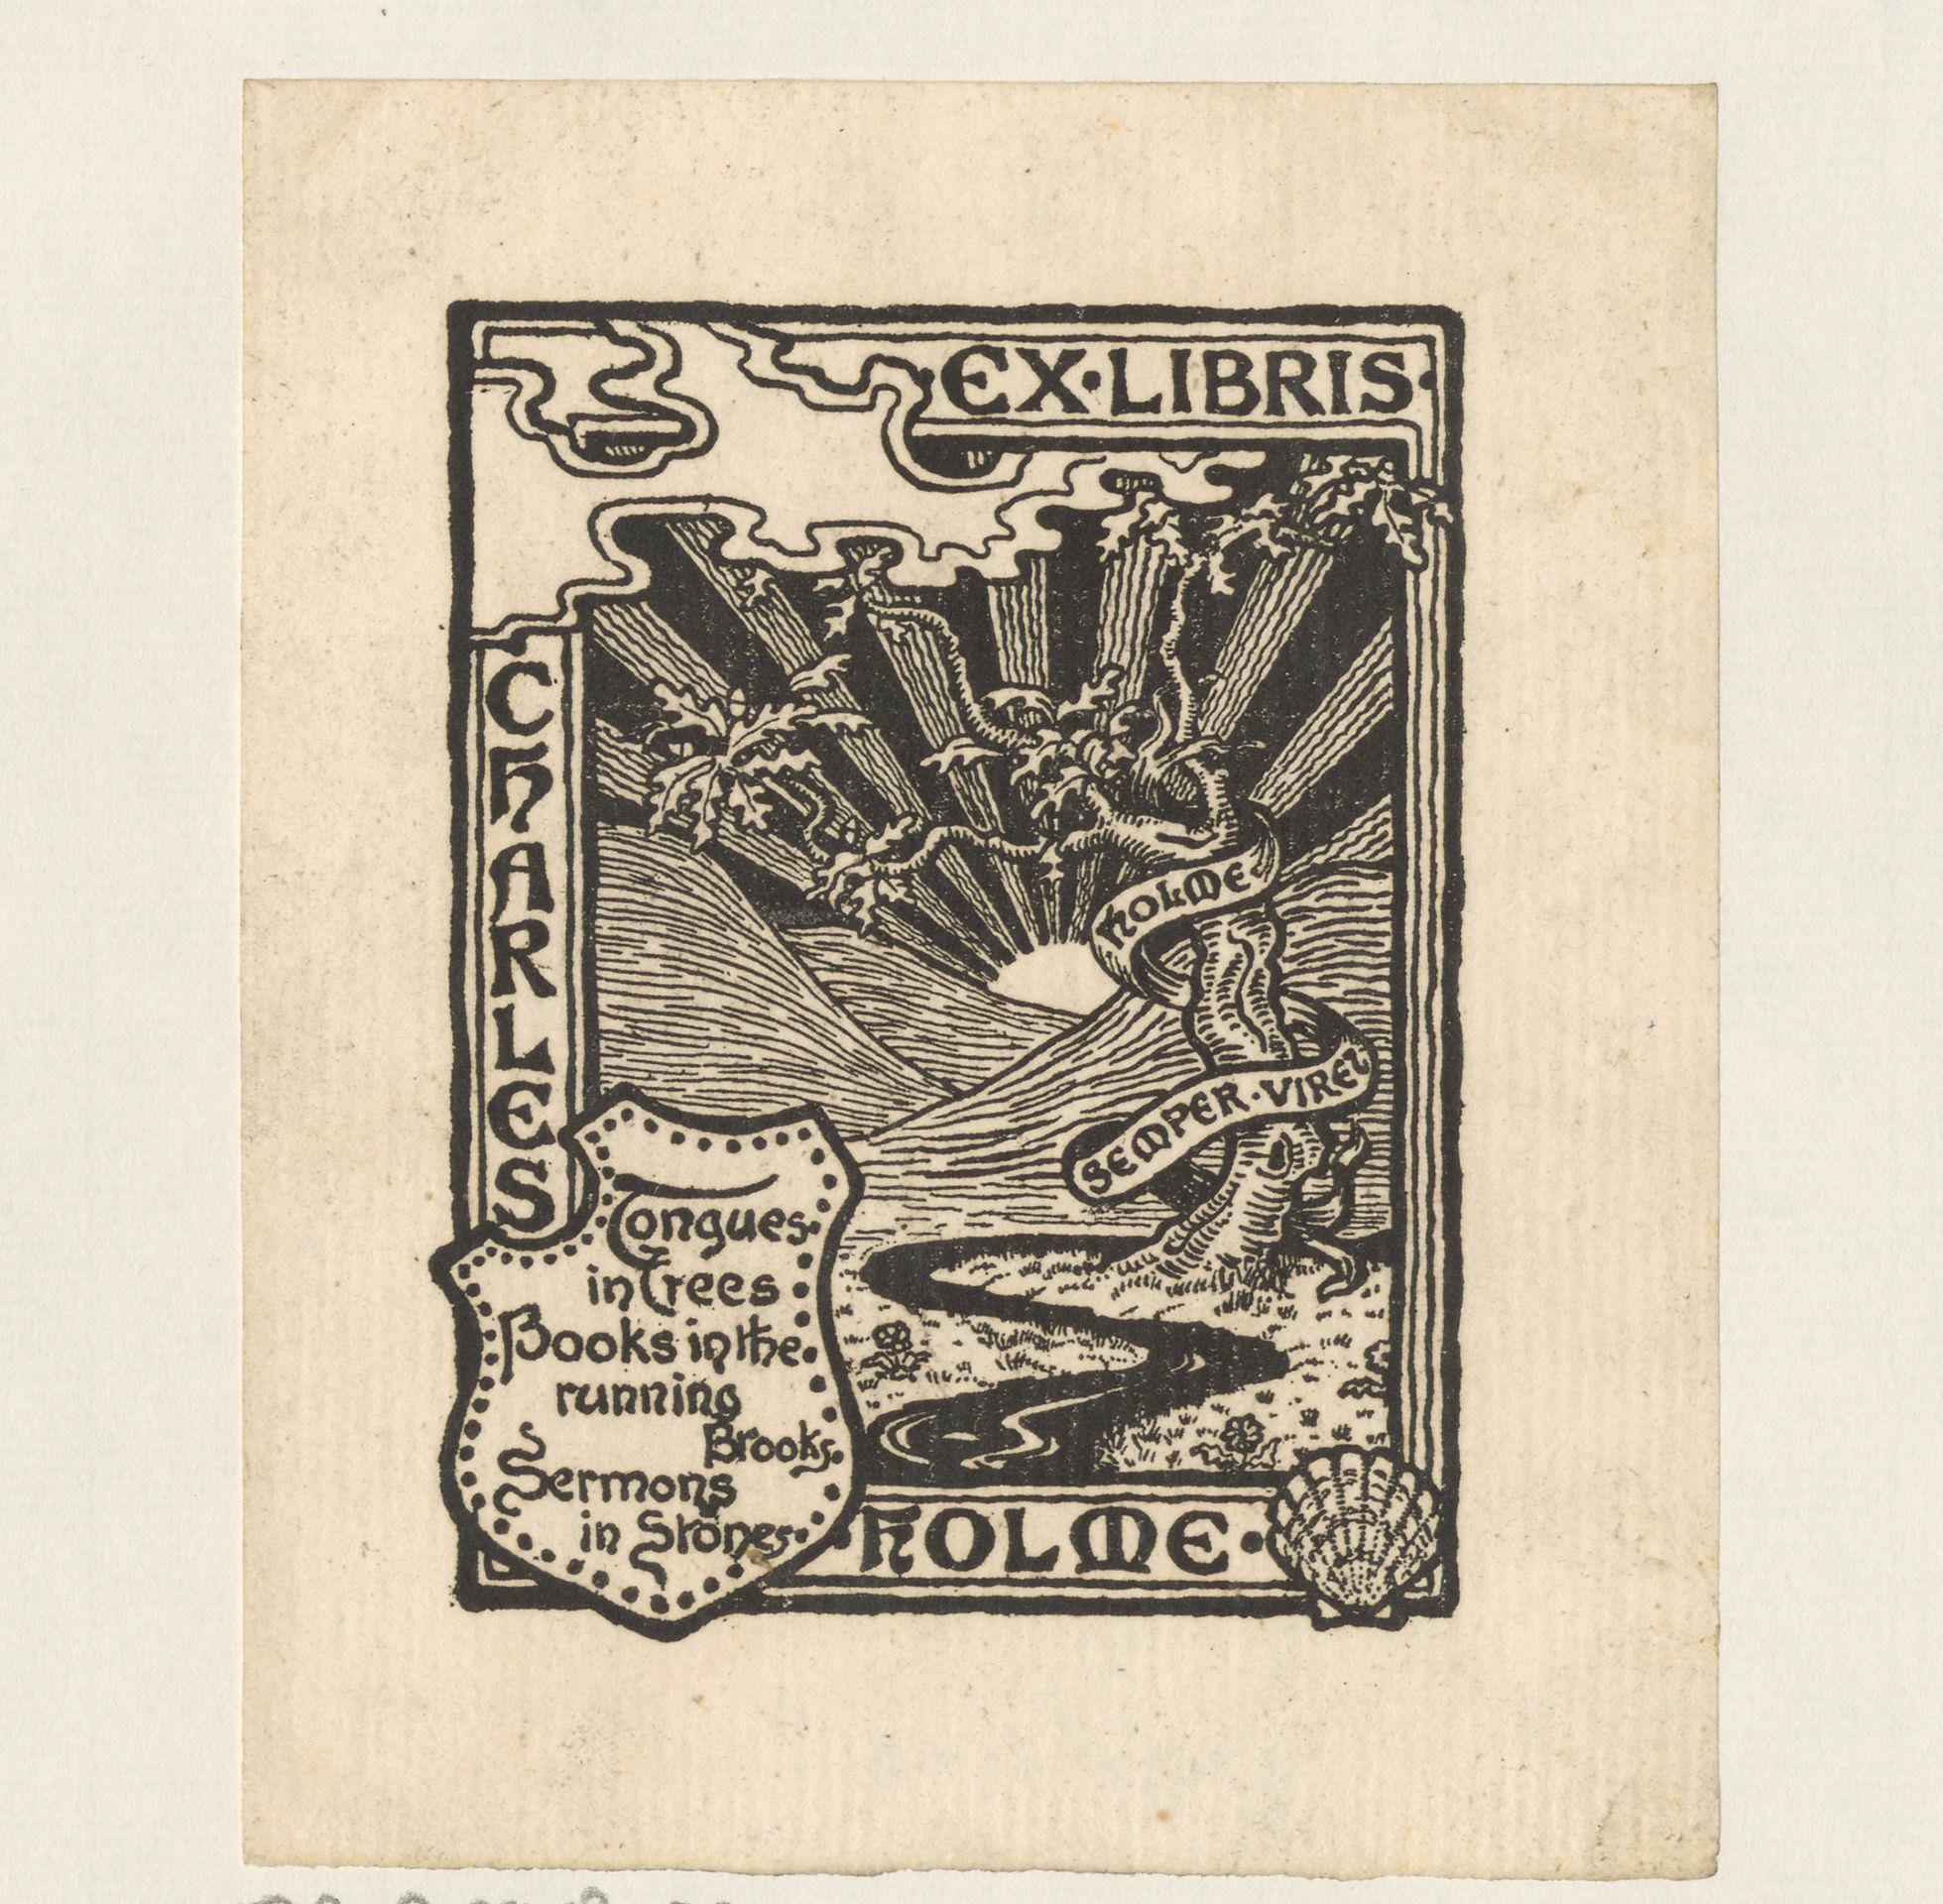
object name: bookplate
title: Tongues in trees (...) Sermons in stones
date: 1889-1923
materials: paper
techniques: printing block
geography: england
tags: charles holme, trees, landscapes with waters, waterscapes, seascapes (in the temperate zone), stars